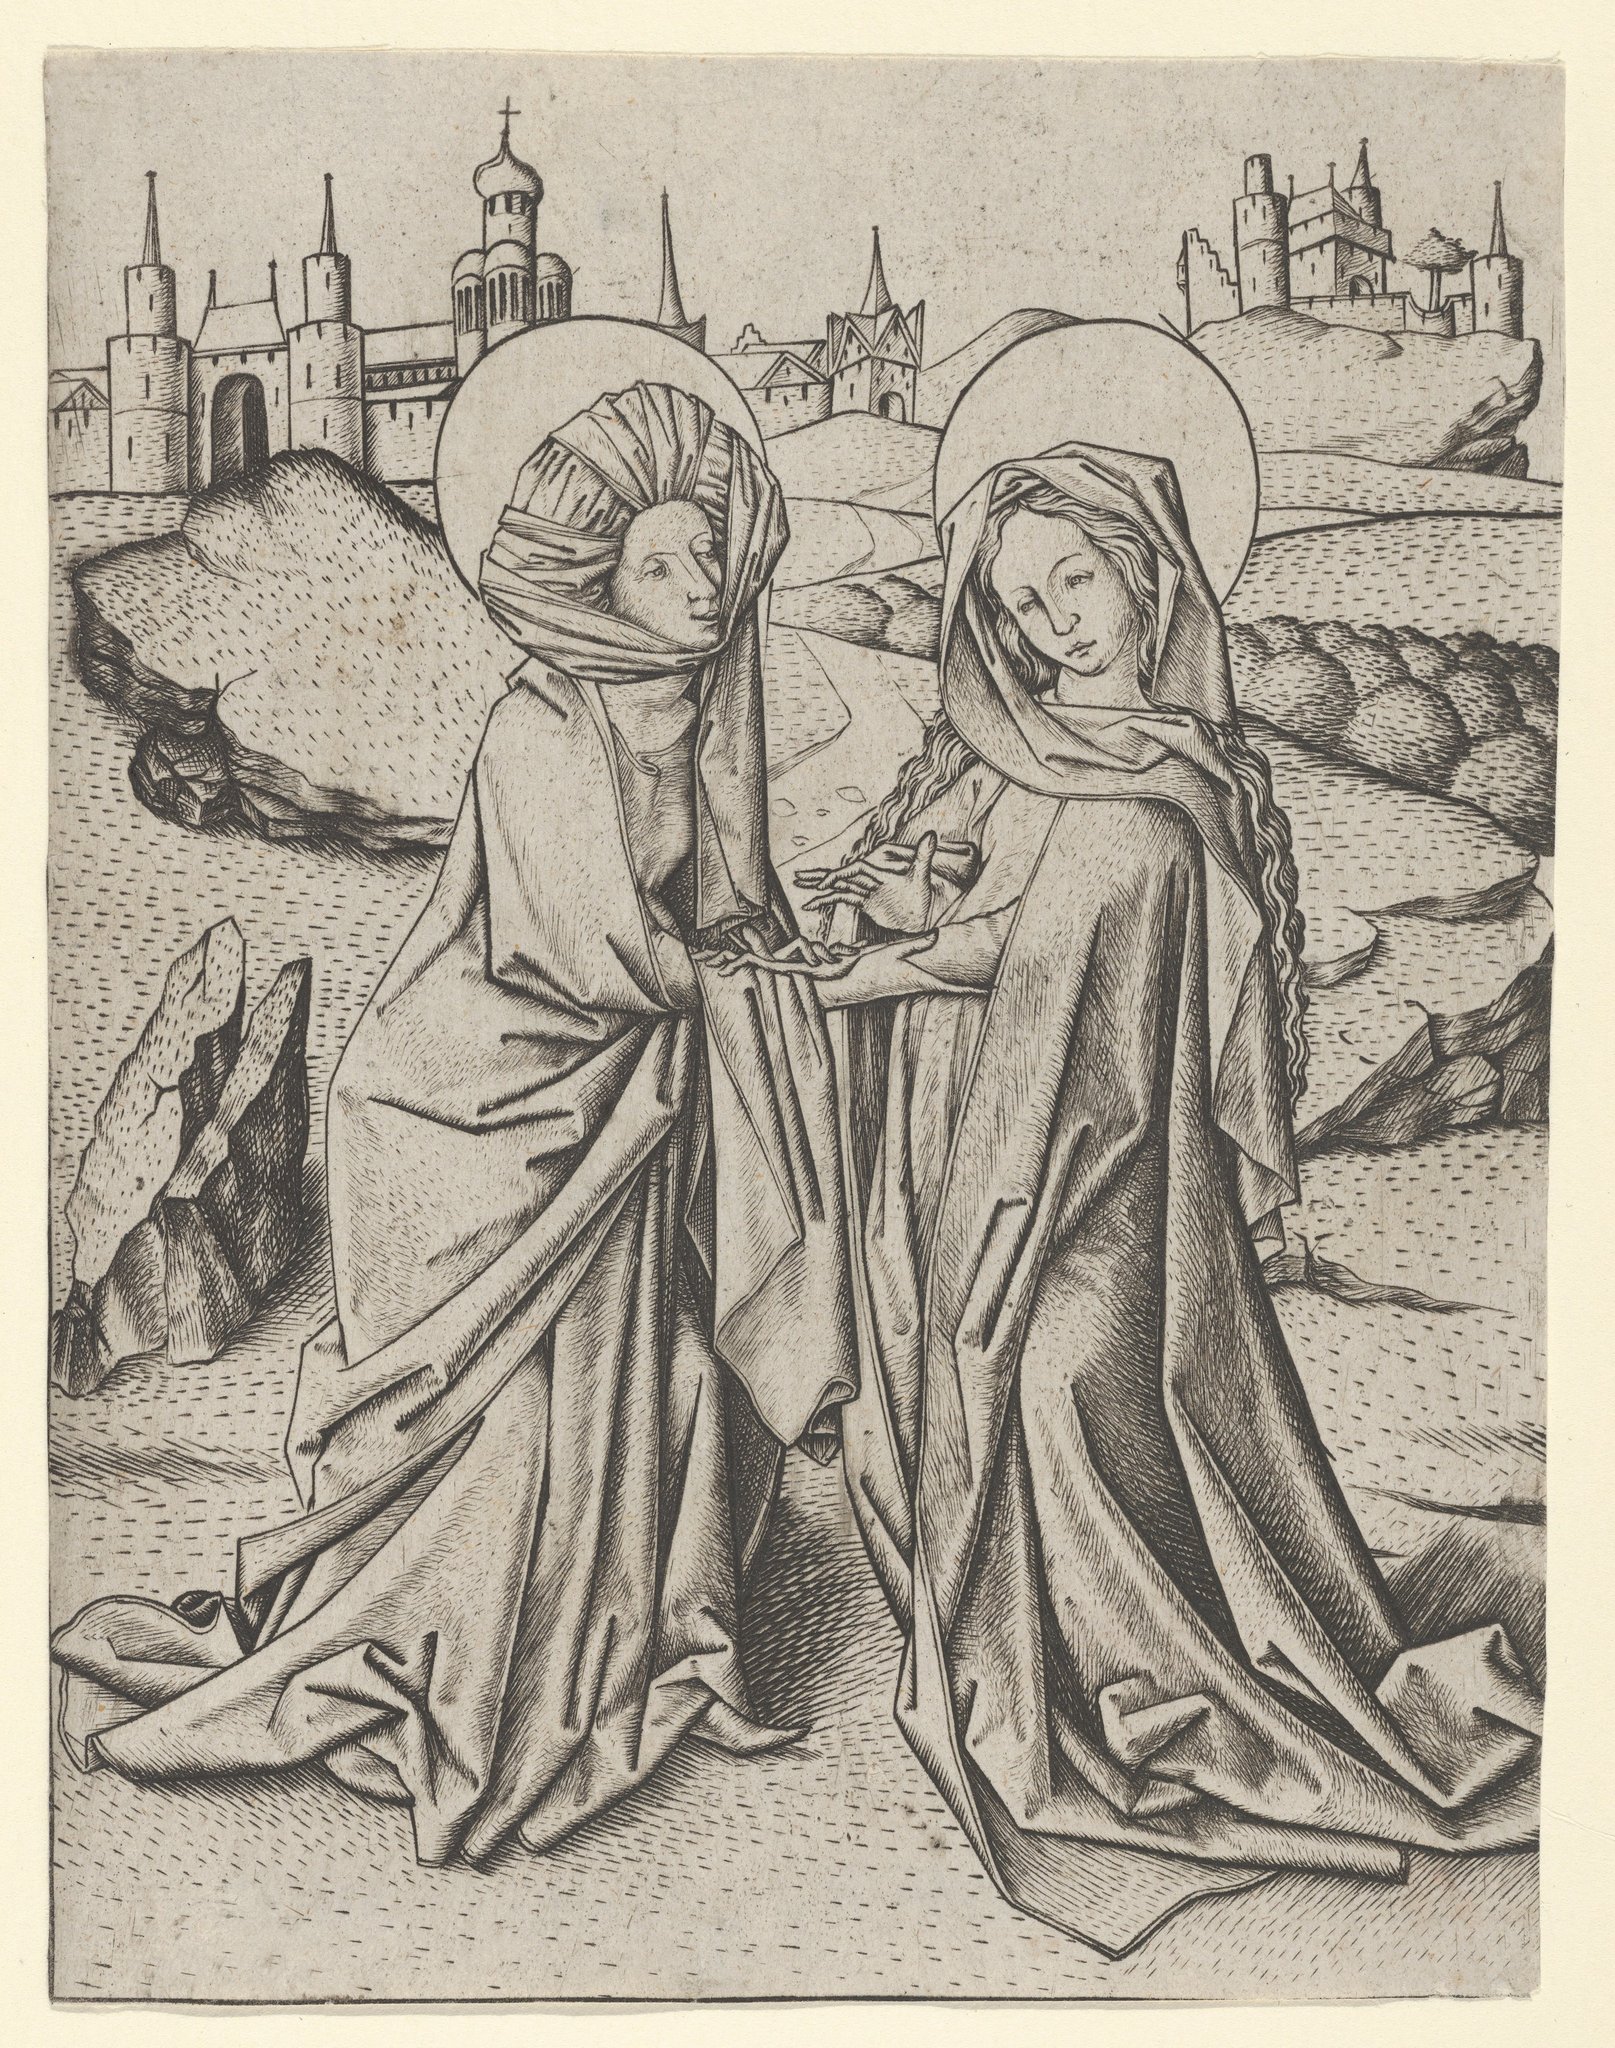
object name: print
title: The Visitation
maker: master es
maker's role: artist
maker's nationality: german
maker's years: 1445-1467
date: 1401-1500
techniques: engraving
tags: buildings,women